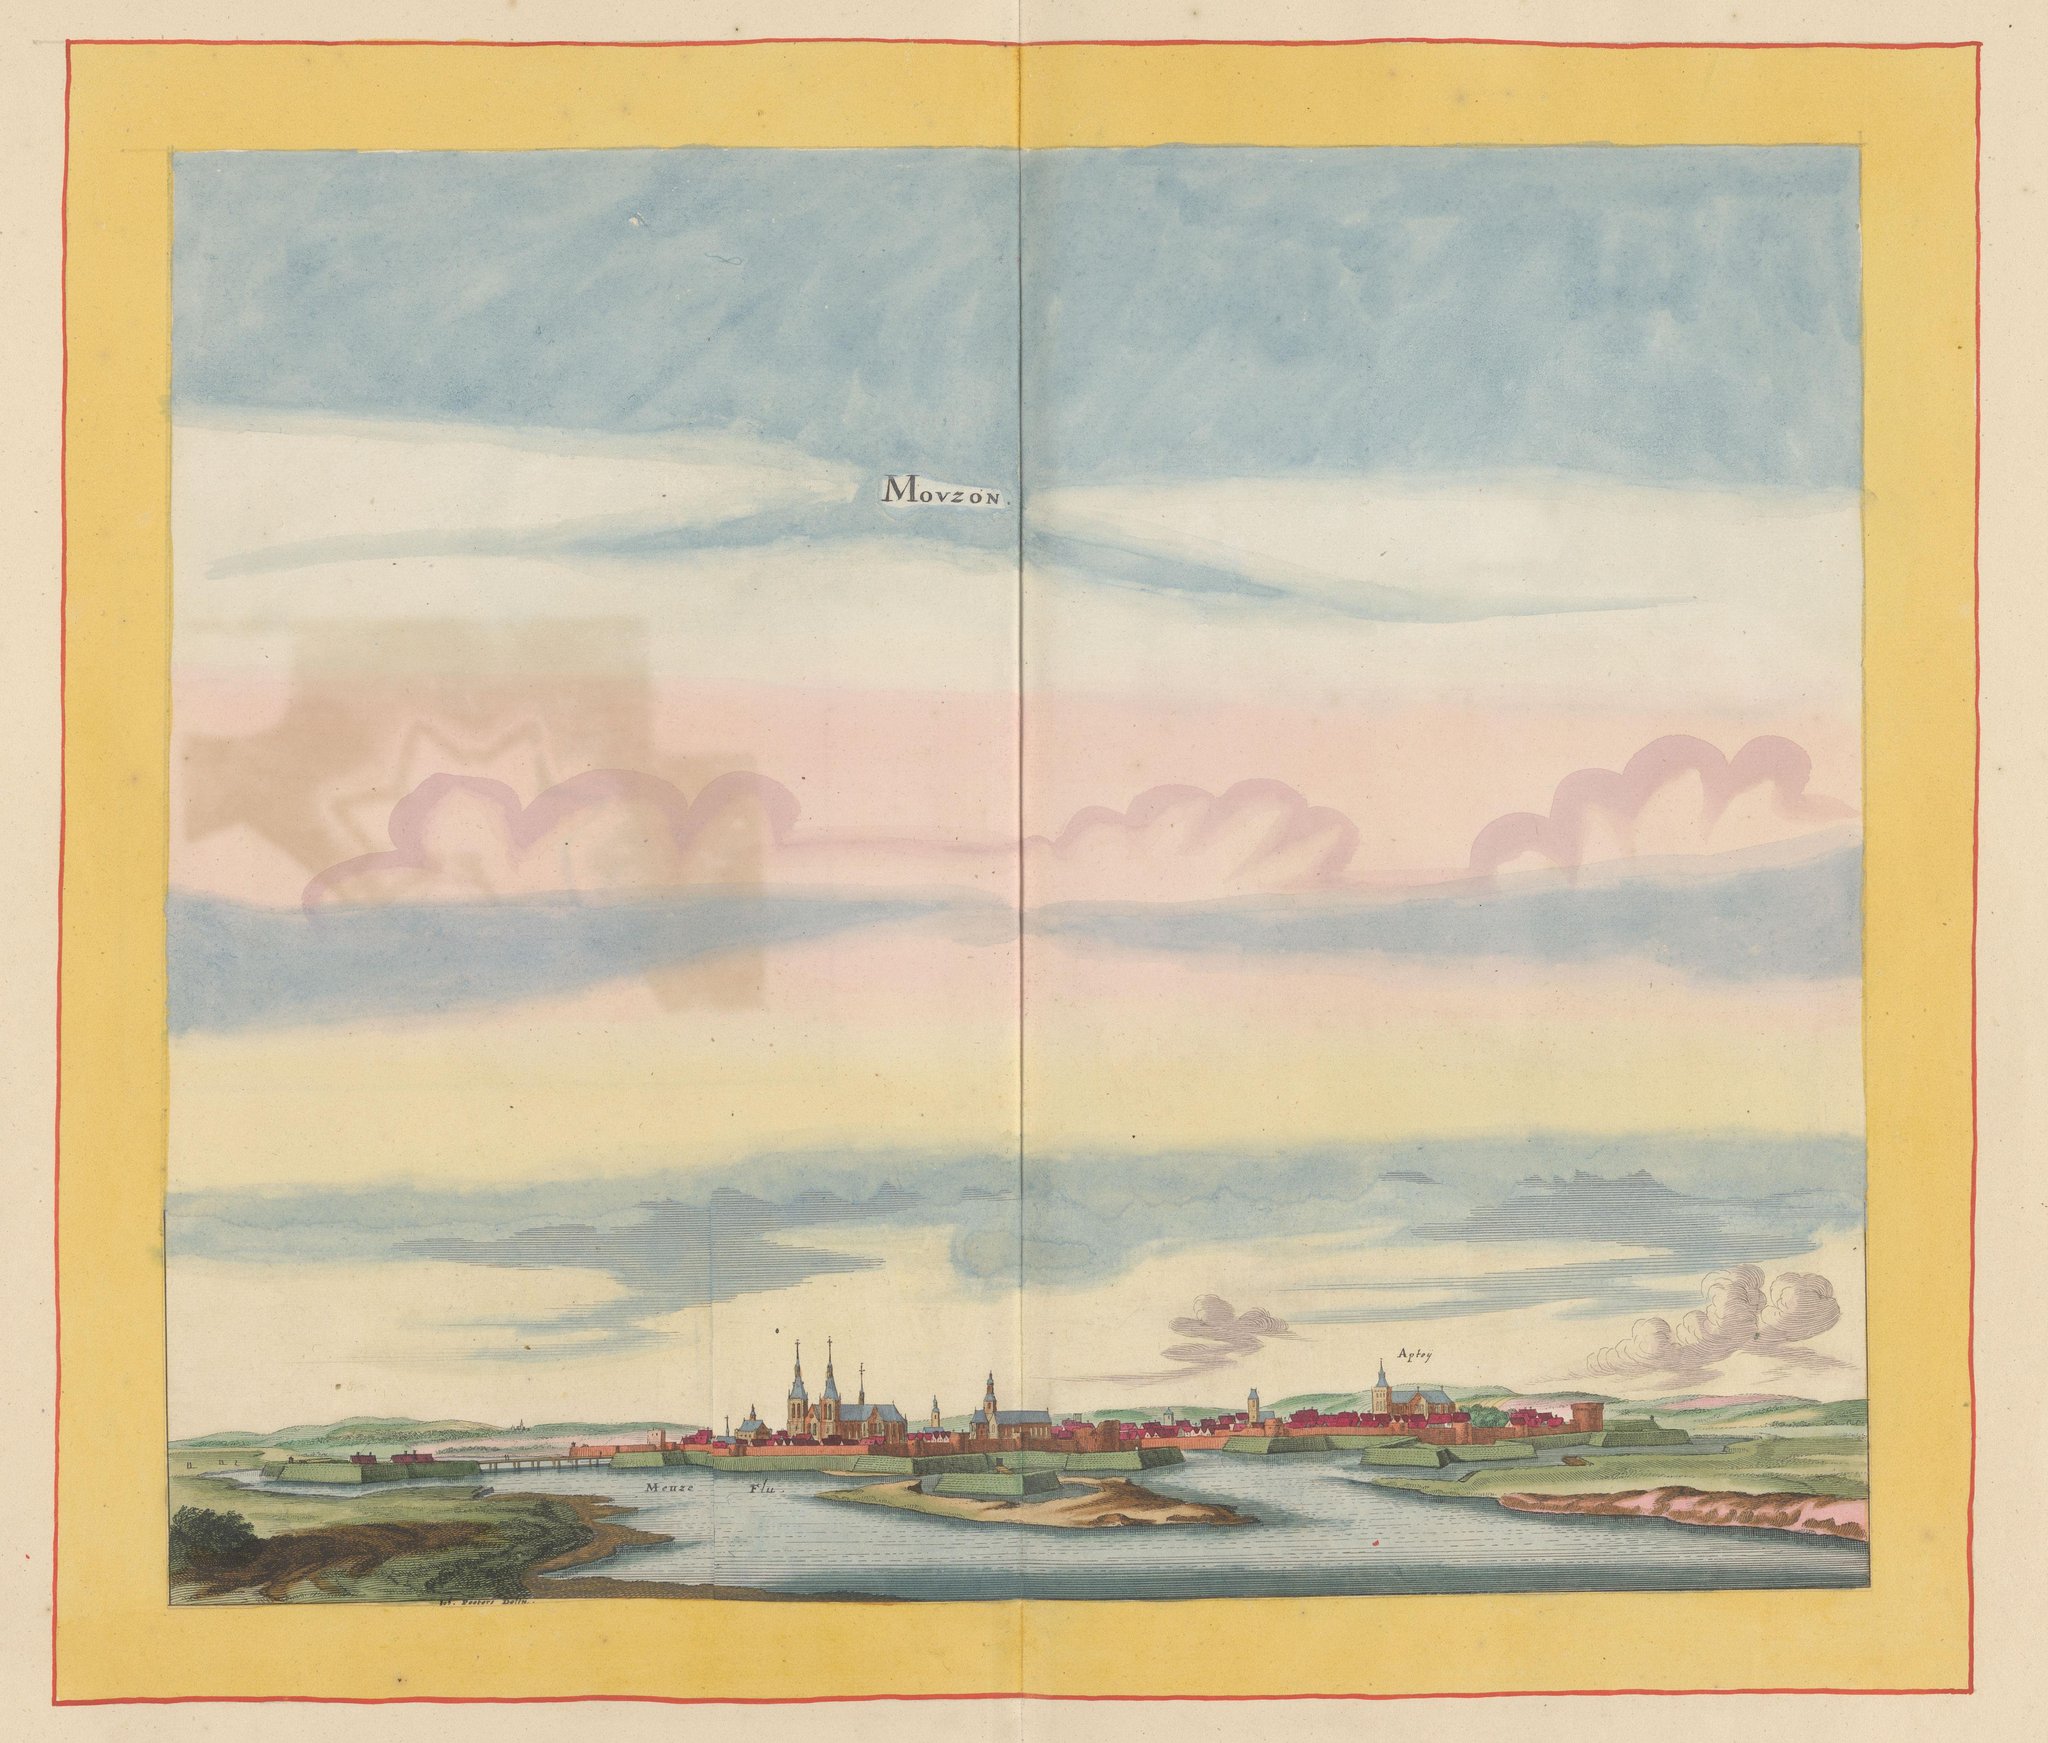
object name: print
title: Gezicht op Mouzon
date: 1656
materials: paper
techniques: engraving, etching, hand coloring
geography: the hague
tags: maps of cities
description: Prent uit: Zeiller, Martin. Topographia Galliae. 13 dln. Frankfurt: Caspar Merian, 1656, dl. 3, na p. 22. Origineel op één blad gedrukt met het gezicht op Sainte-Menehould (RP-P-1957-607-115).